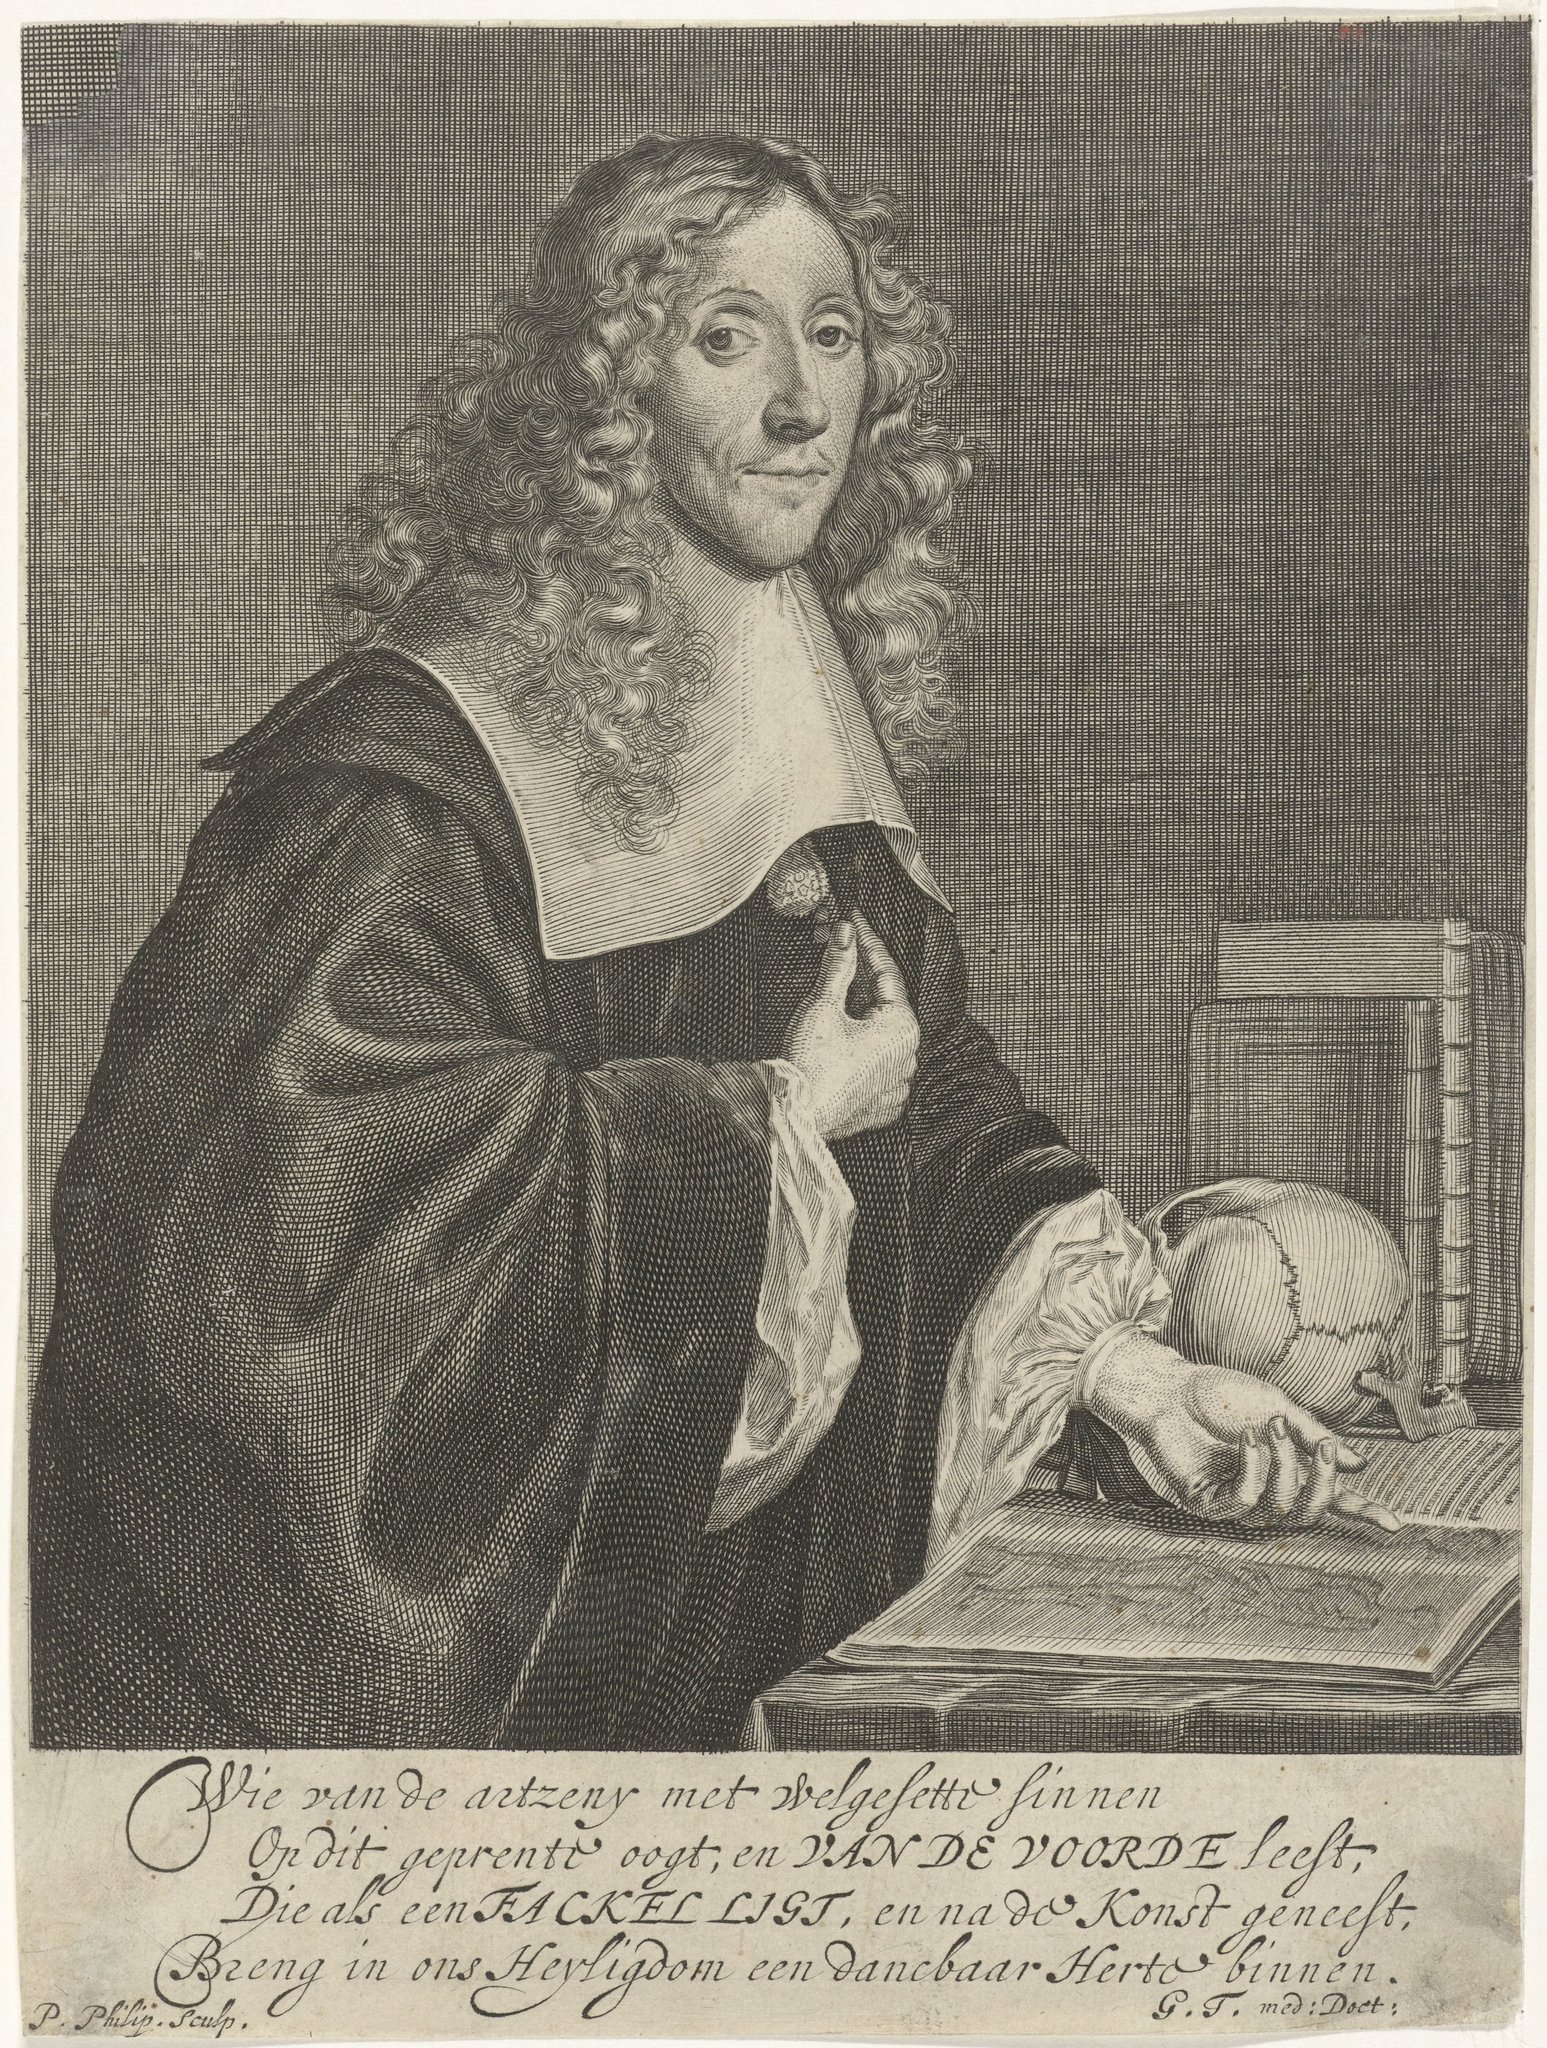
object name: print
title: Portret van Cornelis van de Voorde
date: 1635-1702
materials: paper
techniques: engraving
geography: the hague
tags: middelburg, medicine, medical science, death's head, skull (symbol of death)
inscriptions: collector's mark: Lugt 2228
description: Portret van Cornelis van de Voorde, stadsgeneesheer te Middelburg. Hij staat in zijn studeervertrek en wijst op een medische publicatie. Op zijn bureau een schedel.